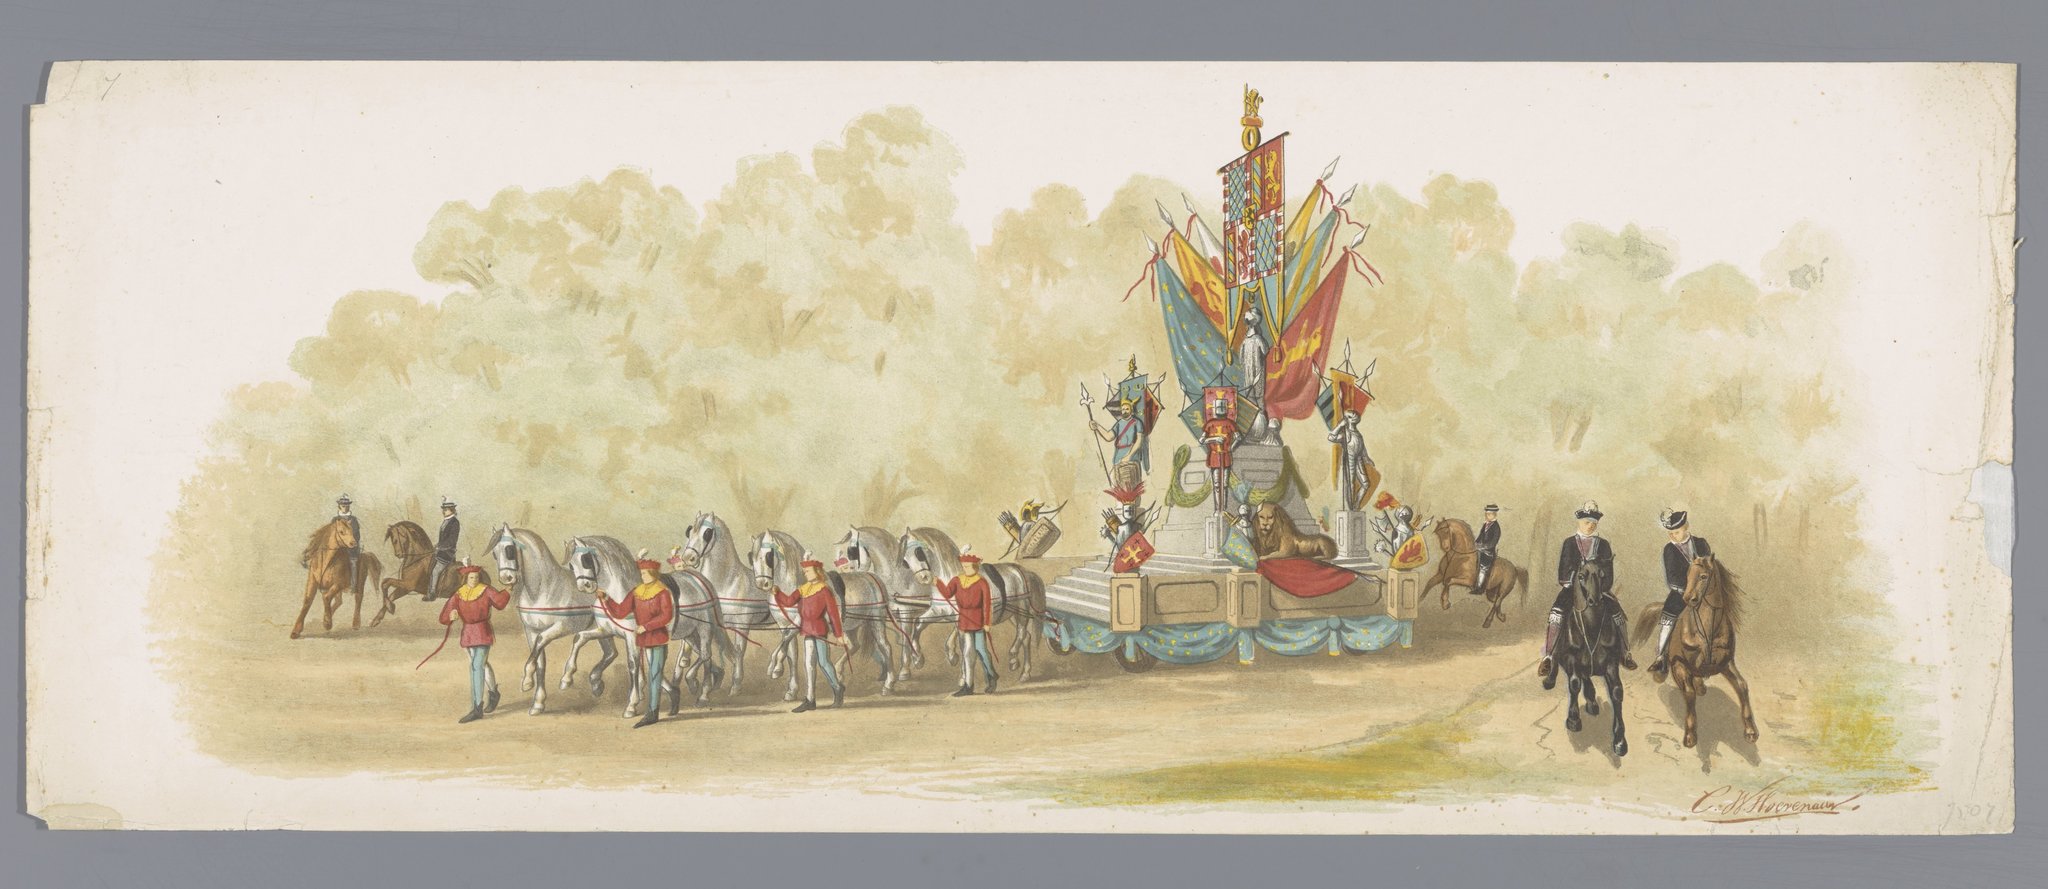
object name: print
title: Utrechtse maskerade van 1876 (zevende plaat)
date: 1876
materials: paper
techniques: chromolithography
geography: amsterdam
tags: earl, charles the bold (duke of burgundy), students' pageant, costumes used in pageants, commemoration of the founding of a university, utrecht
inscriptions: collector's mark: Lugt 2228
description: Zevende en laatste deel van de optocht. Onderdeel van een serie van zeven platen plus titelprent en verklaring van de gecostumeerde optocht georganiseerd door de studenten van de Utrechtse Hogeschool ter viering van de 48e lustrum op 27 juni 1876. De optocht stelt voor de intocht van Karel te Stoute te Zutphen op 4 augustus 1473.